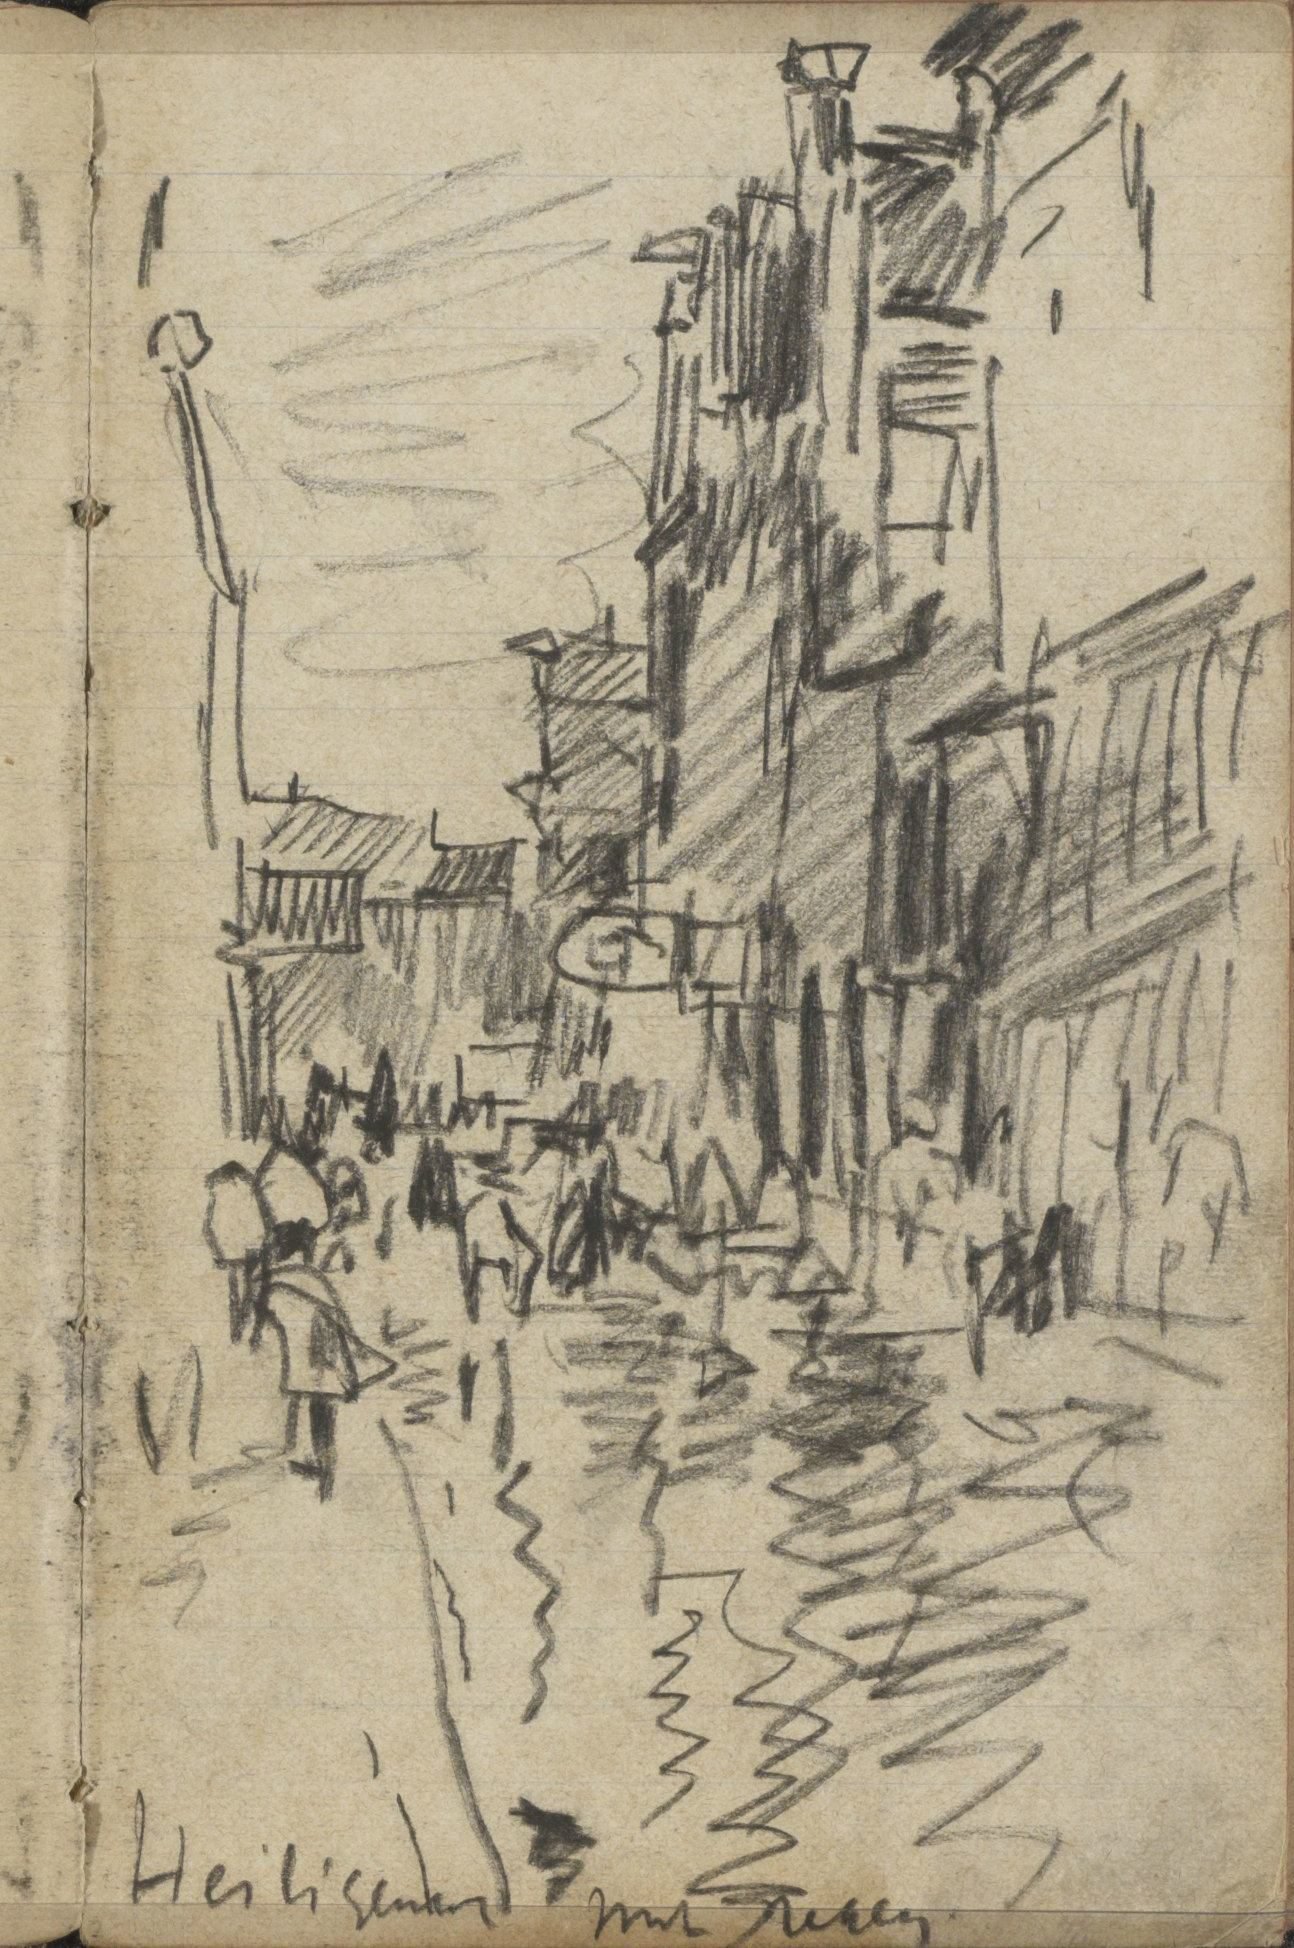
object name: sketchbook leaf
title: Heiligeweg met regen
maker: george hendrik breitner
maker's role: draughtsman, painter, print maker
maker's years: 1857-1923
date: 1893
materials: chalk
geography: amsterdam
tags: civic architecture; edifices; dwellings, street (+ city(-scape) with figures, staffage)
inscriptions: annotation: ‘Heiligenweg [sic] met regen’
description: Pagina 4 uit een schetsboek met 41 bladen.